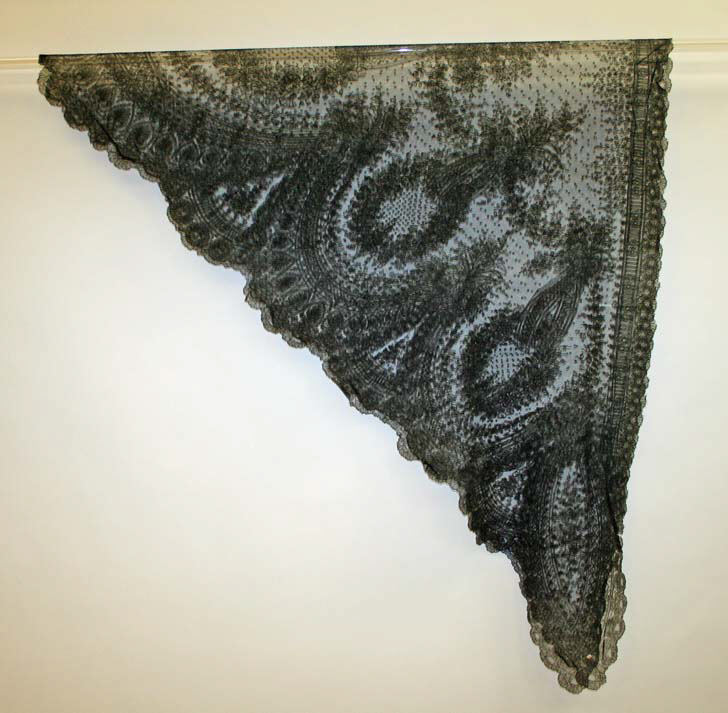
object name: shawl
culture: american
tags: flowers